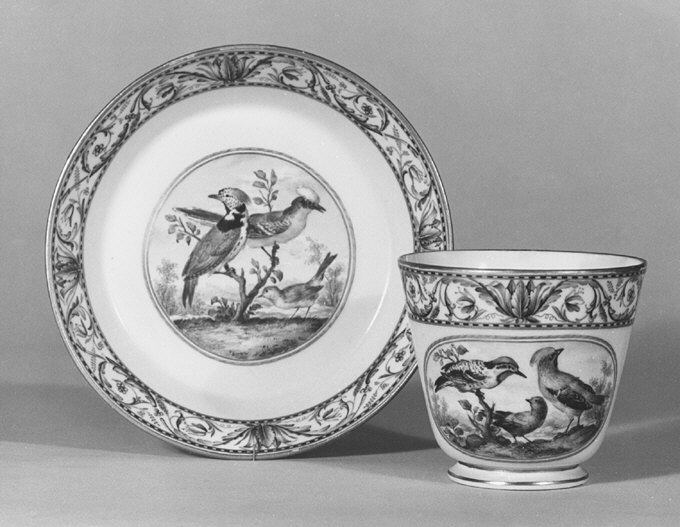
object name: saucer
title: Saucer (part of a service)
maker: meissen manufactory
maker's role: manufactory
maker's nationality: german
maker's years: 1710-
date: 1780-1785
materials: hard paste porcelain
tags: birds,flowers